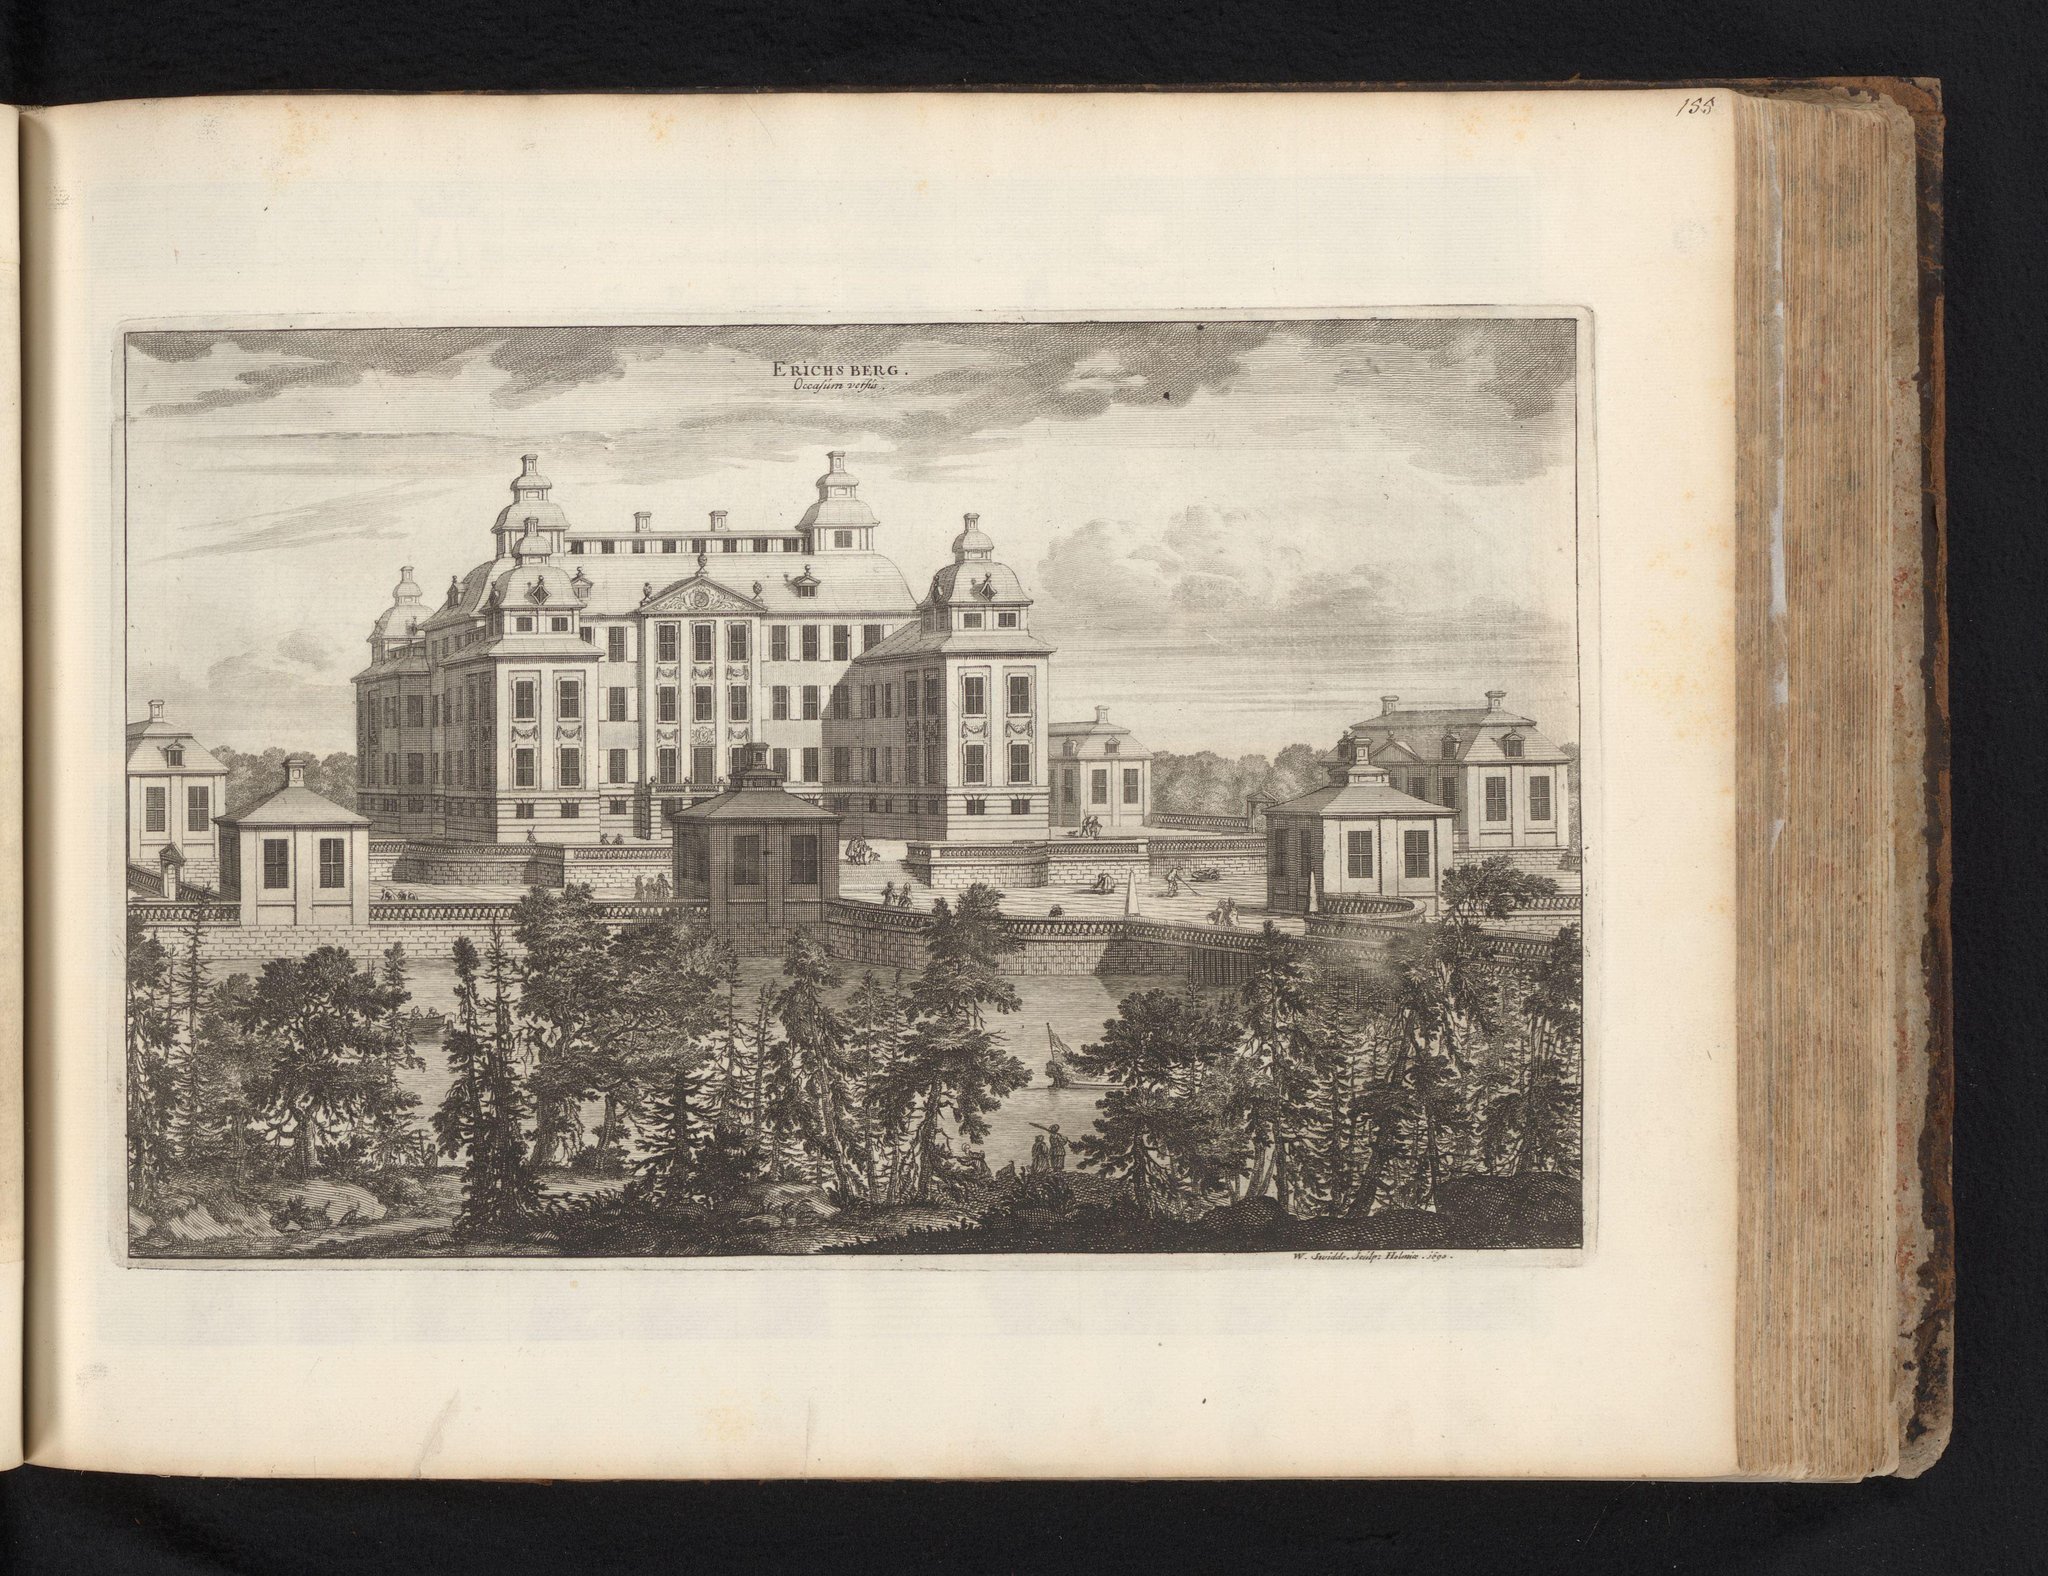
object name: album leaf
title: Suecia Antiqua et Hodierna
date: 1690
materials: paper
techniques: etching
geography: stockholm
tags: housing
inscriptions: date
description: Kungliga Biblioteket, 'Suecia': http://www.kb.se/samlingarna/Kartor-bilder/Suecia-antiqua/ (geraadpleegd november 2016).